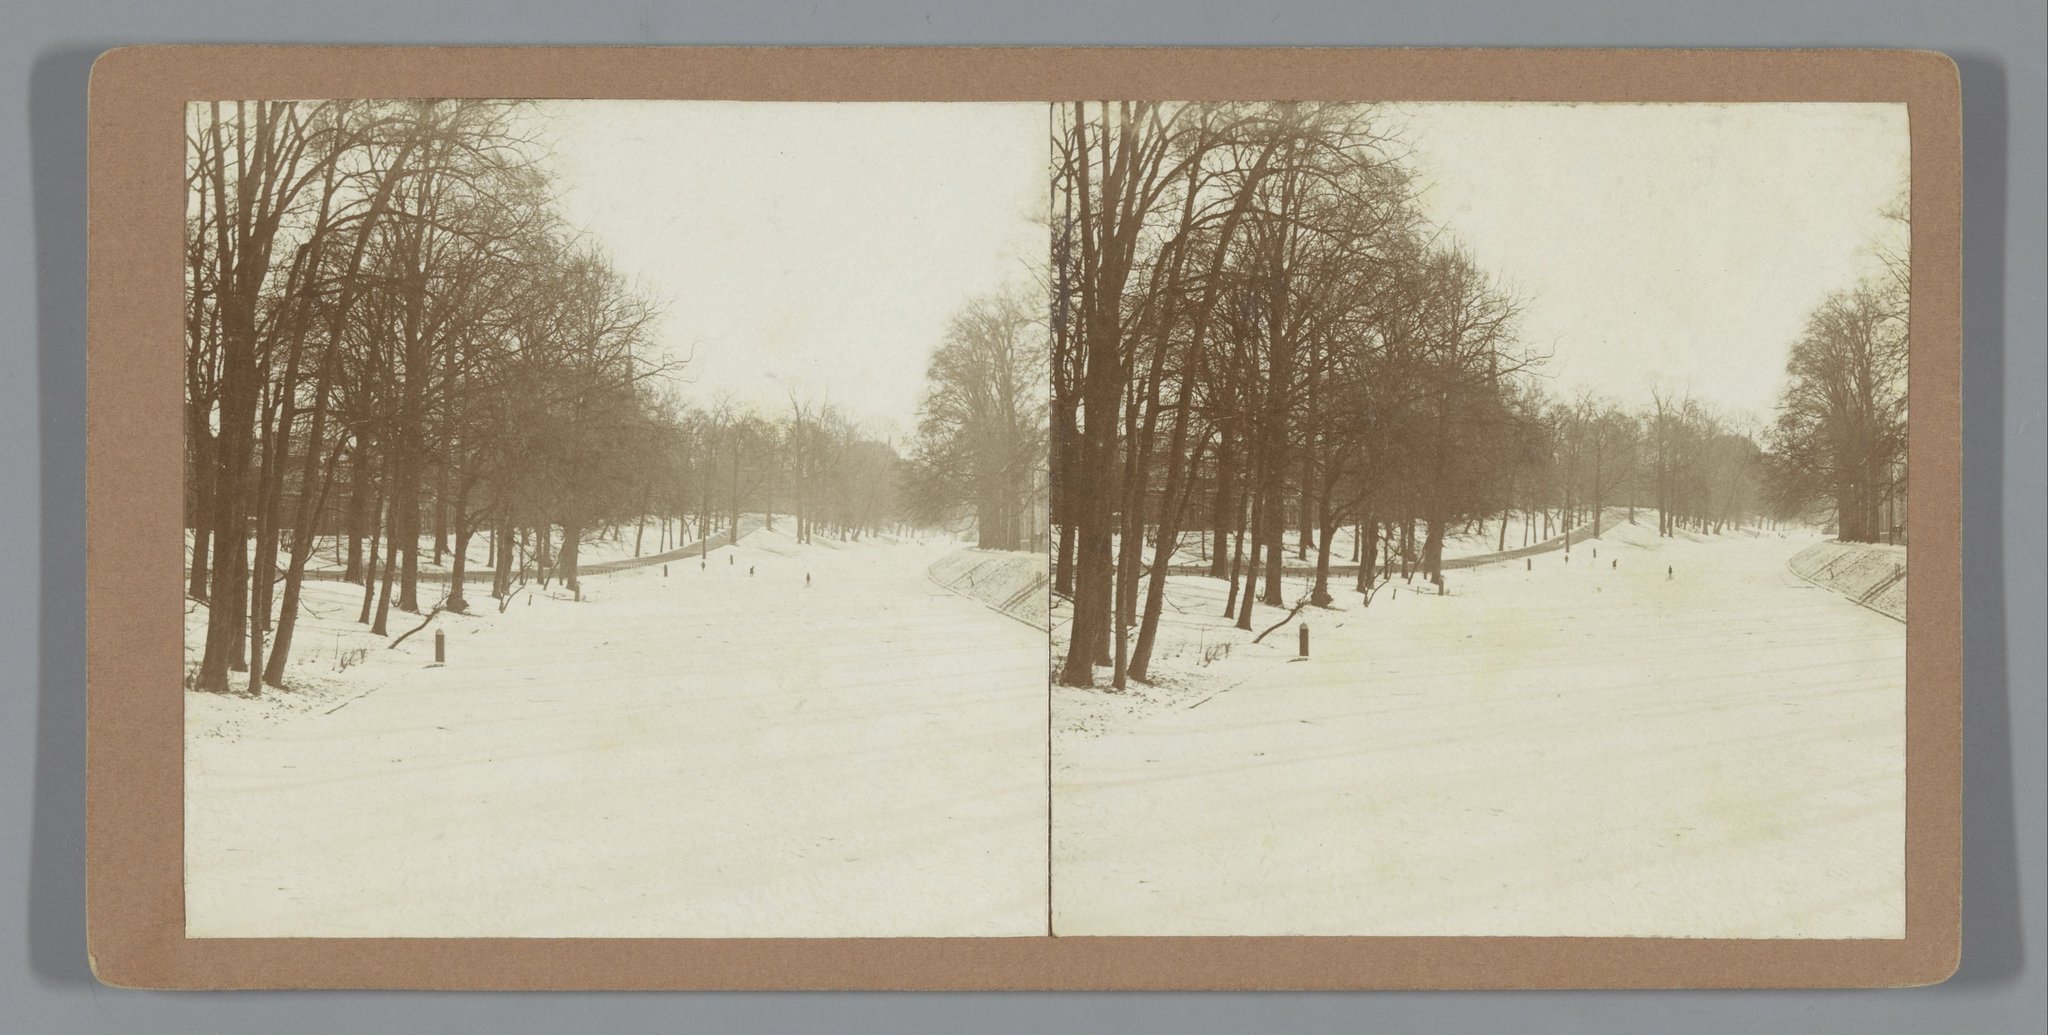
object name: stereograph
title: Bevroren Catharijnesingel, gezien vanaf de Bartholomeusbrug, Utrecht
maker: Anonymous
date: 1902-1917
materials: paper, cardboard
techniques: gelatin silver print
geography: utrecht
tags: canals, waters (in city)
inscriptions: number: ‘No 393’